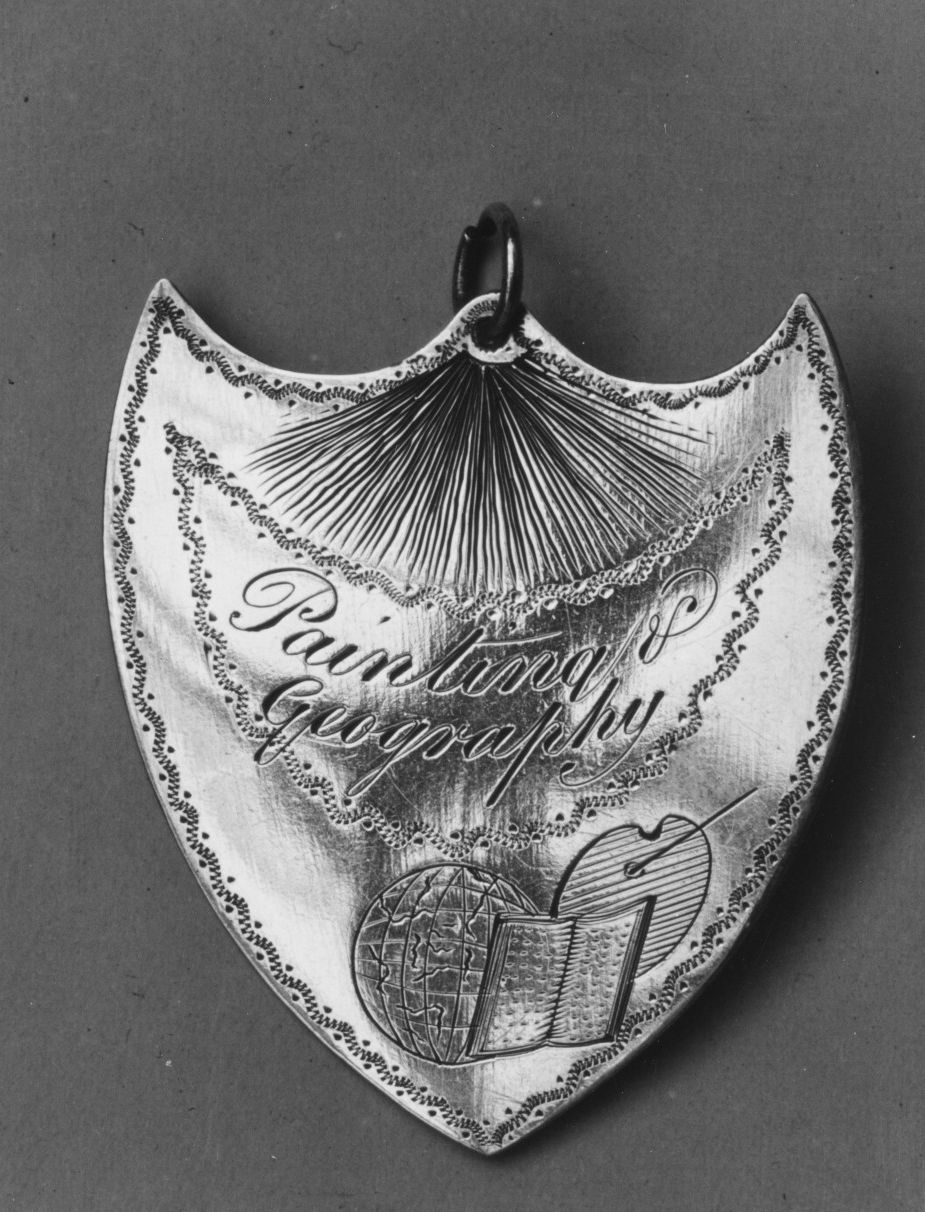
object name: medal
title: Scholarship Medal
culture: american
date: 1770-1830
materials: silver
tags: books,globes